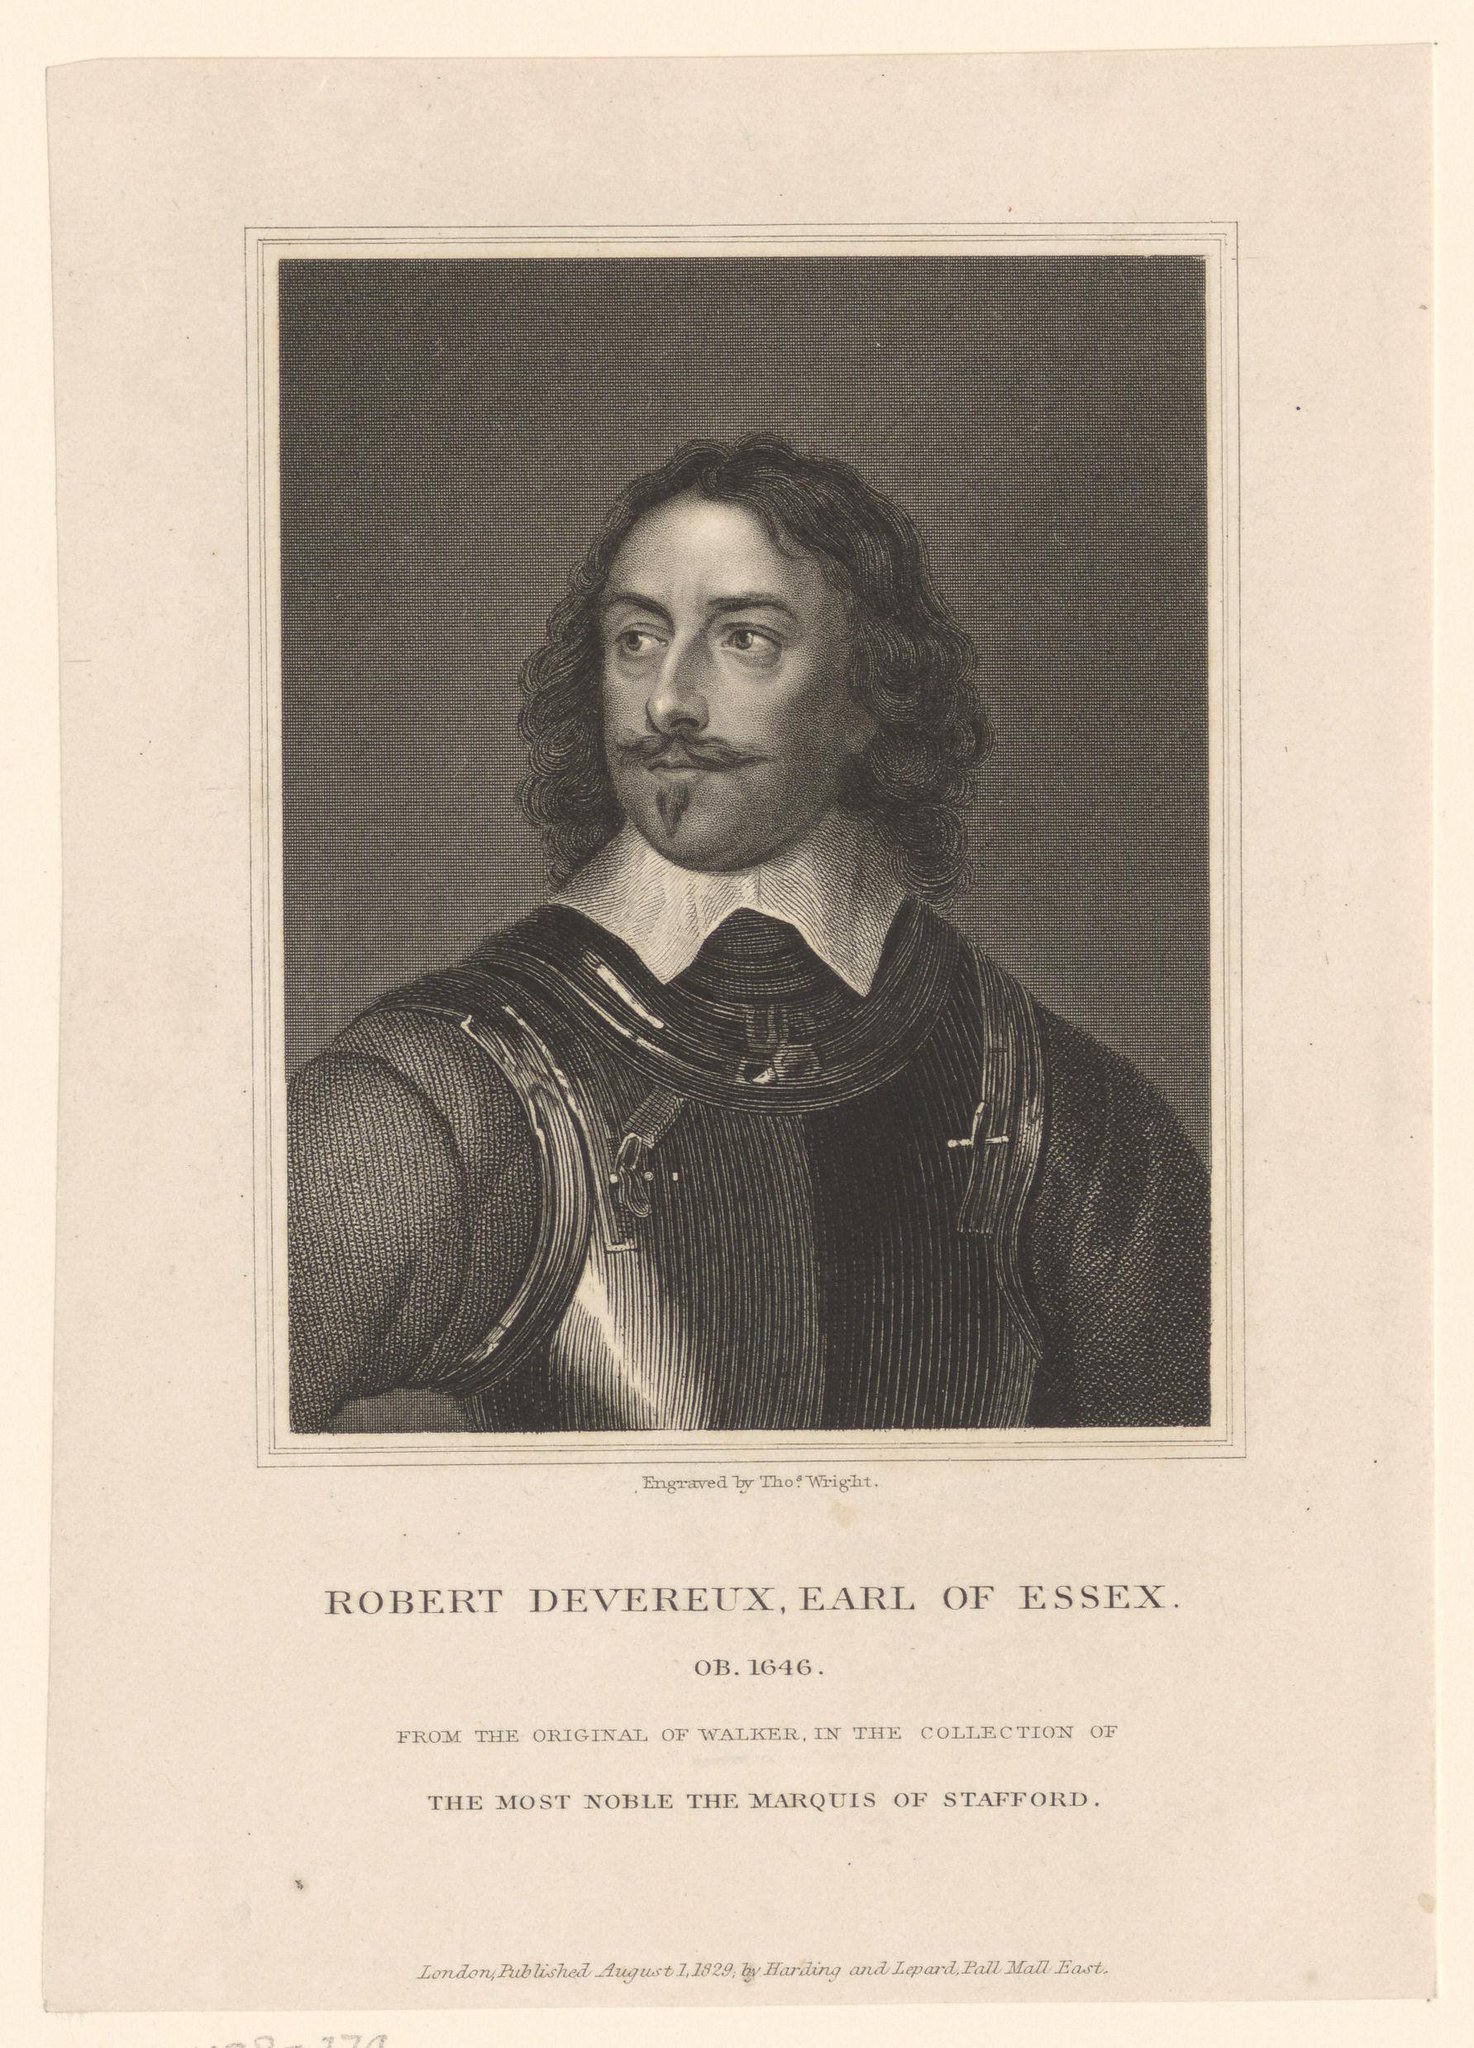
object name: print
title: Portret van Robert Devereux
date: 1829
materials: paper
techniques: etching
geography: london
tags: politician, historical persons, politician, e.g. party leader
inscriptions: collector's mark: Lugt 2228